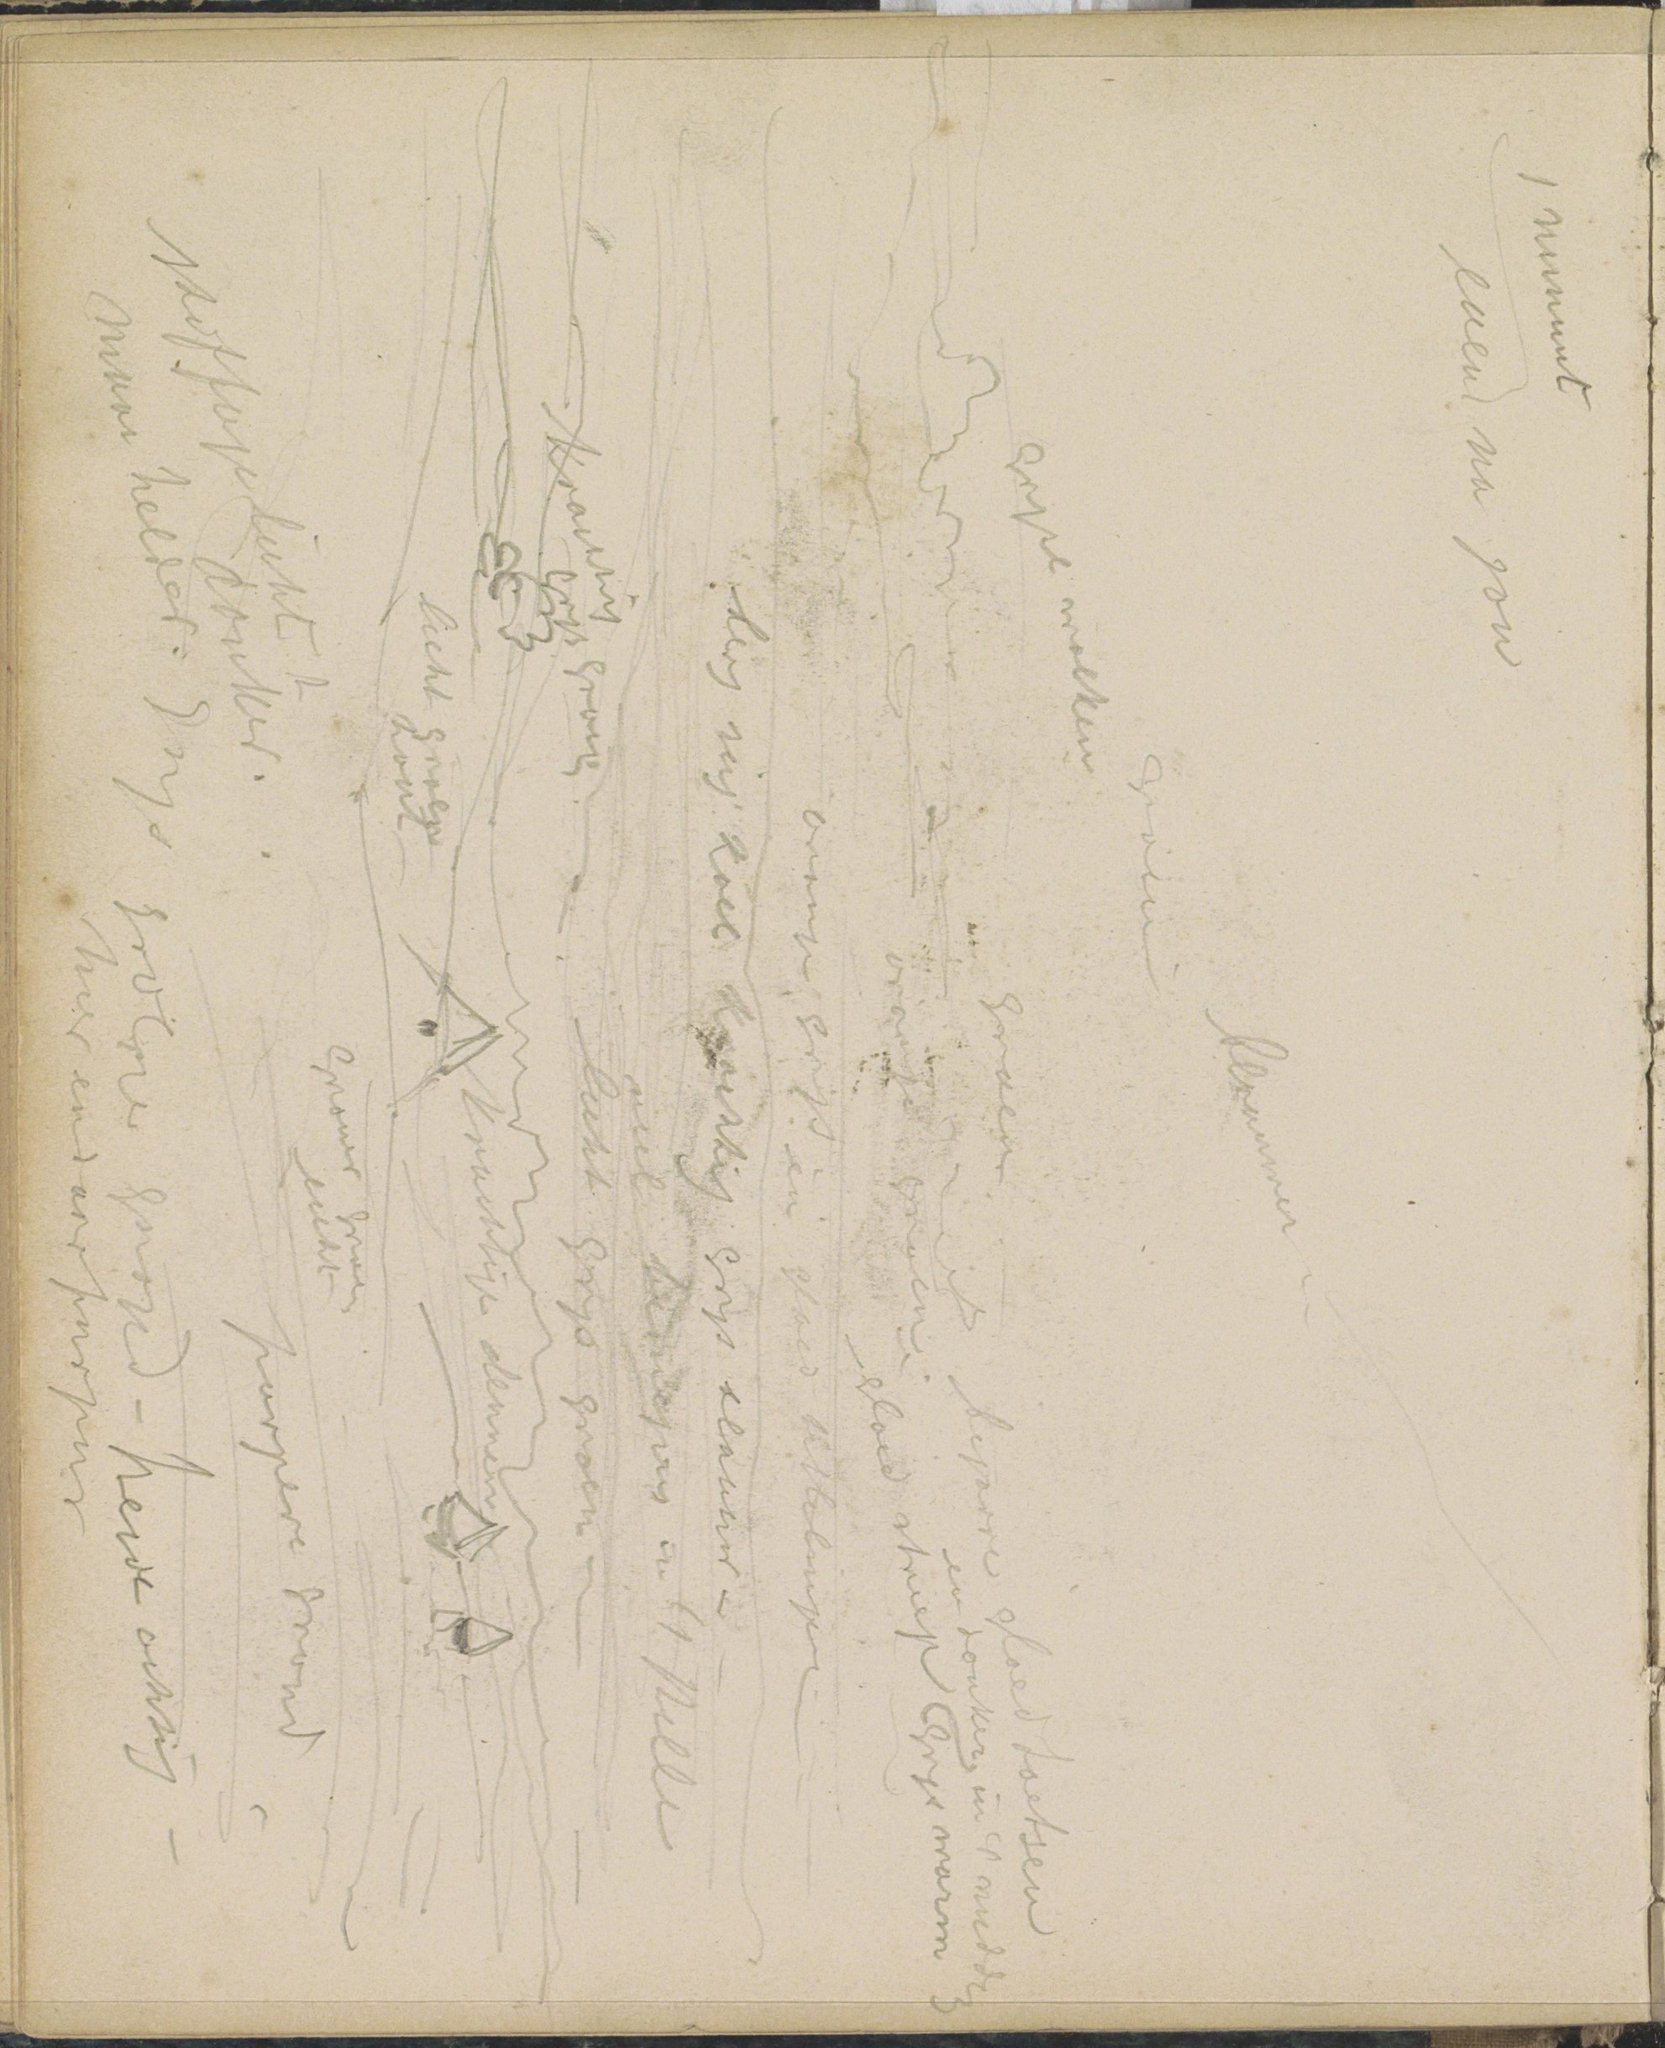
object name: sketchbook leaf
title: Landschap met dennebomen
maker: johannes tavenraat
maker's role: draughtsman, painter, print maker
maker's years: 1809-1881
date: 1841-1853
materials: paper, pencil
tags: landscapes, trees: pine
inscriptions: annotation: ‘1 minuut/ even na zon’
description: Blad 72 verso uit een schetsboek met 87 bladen.